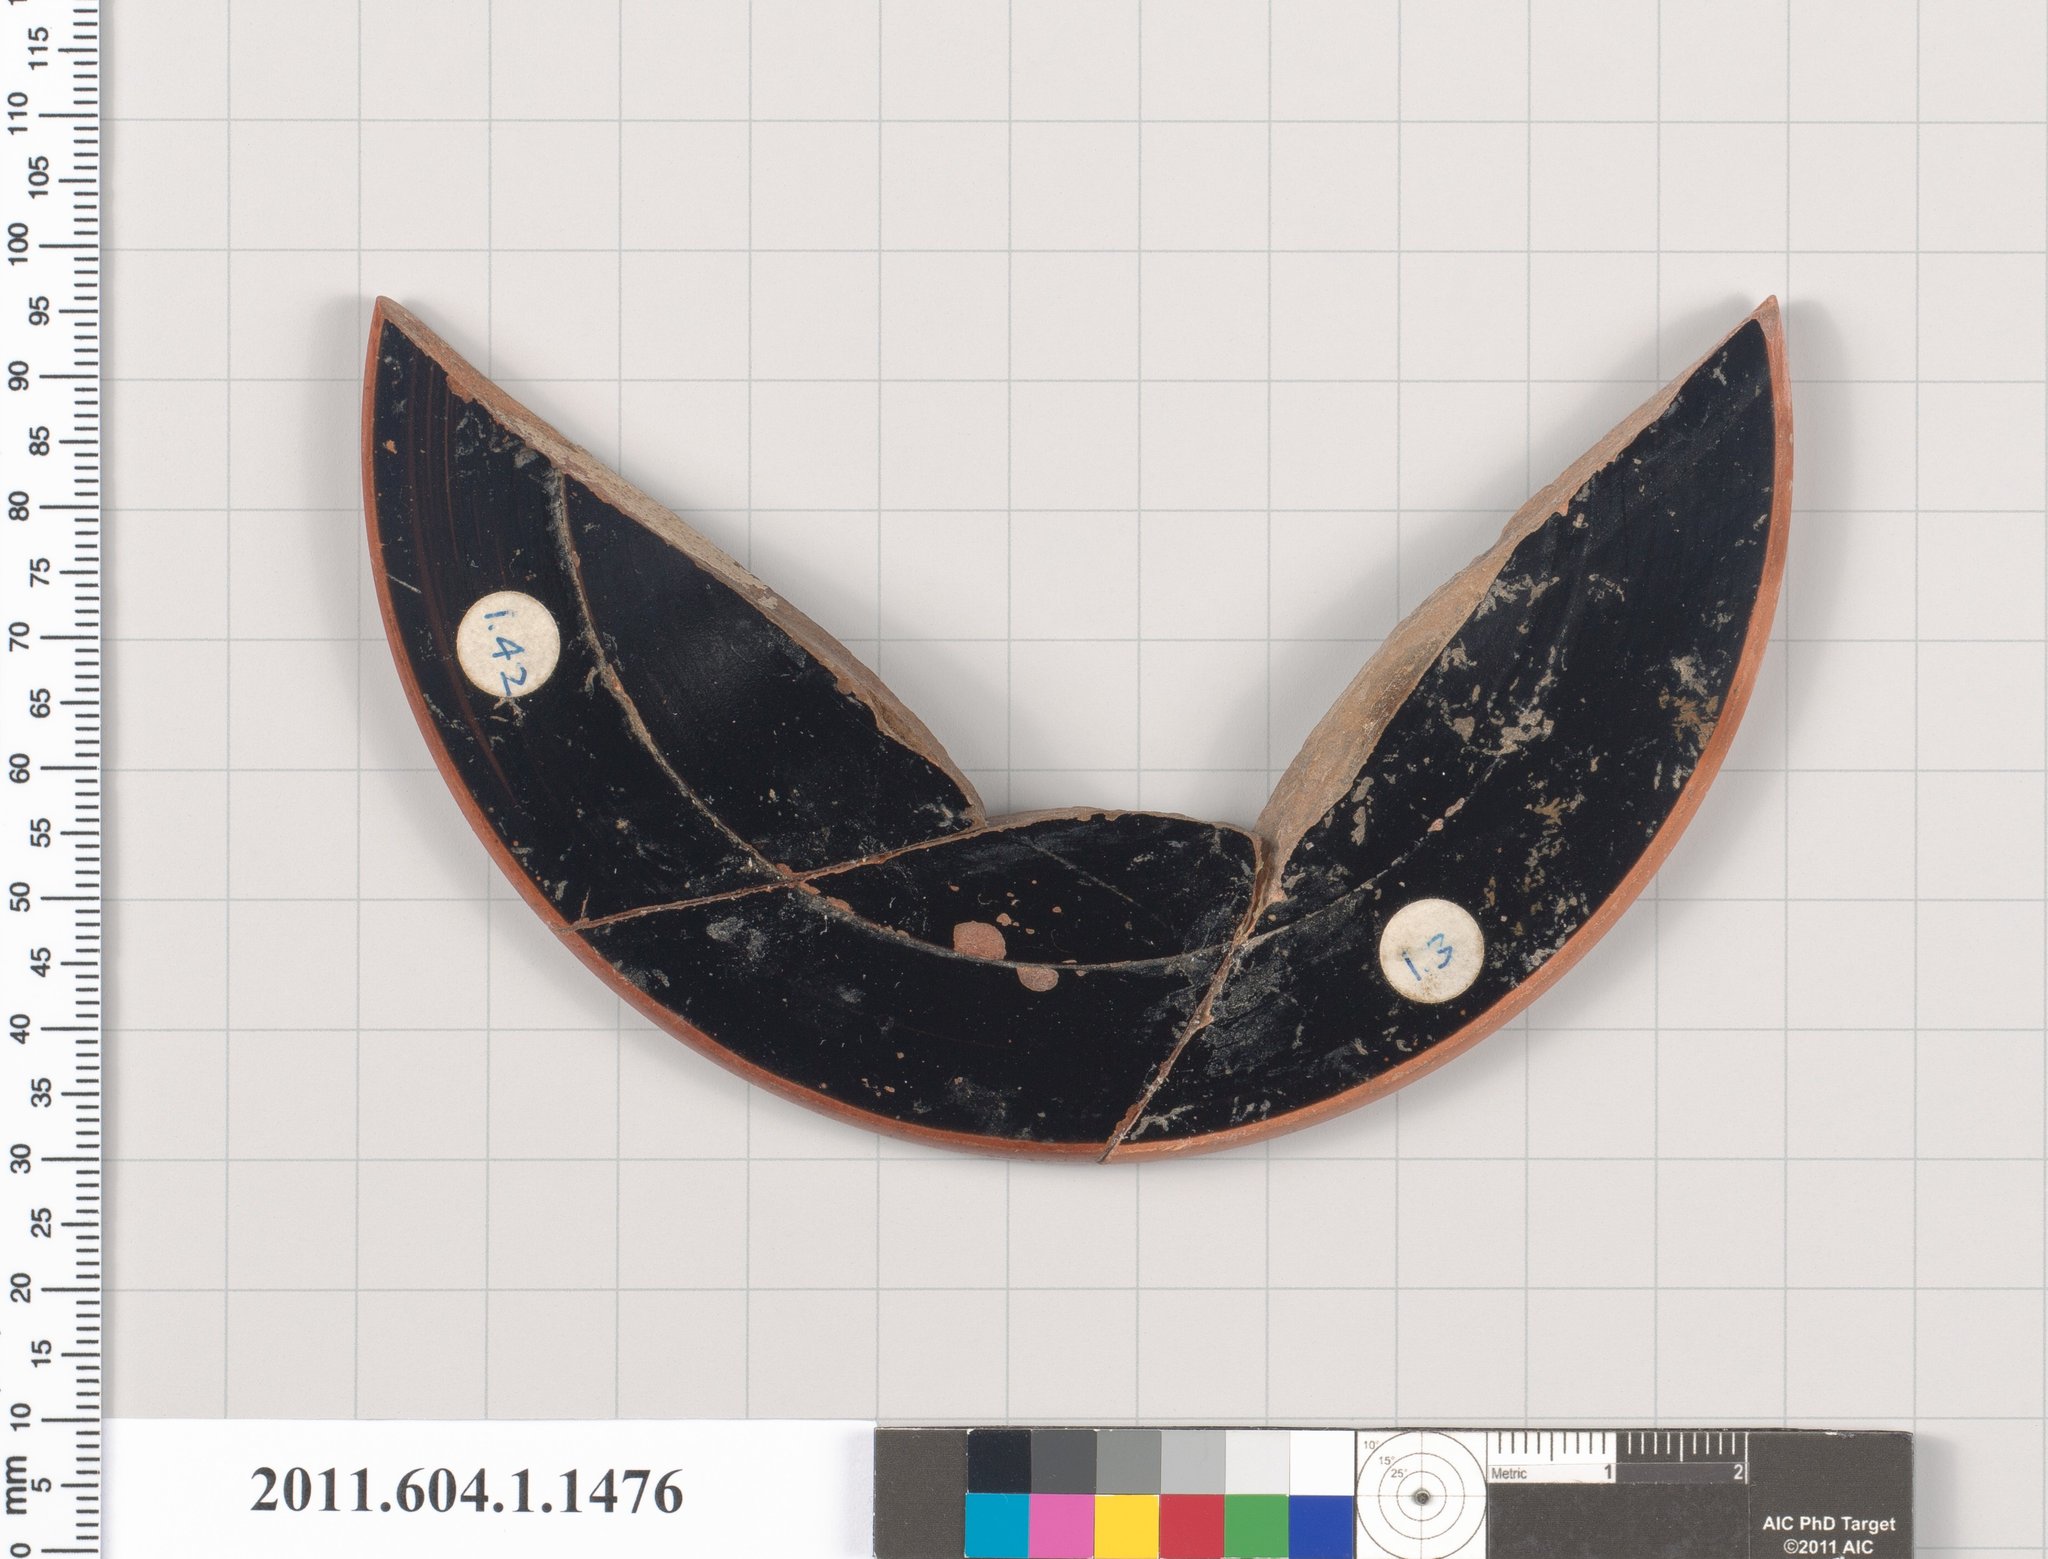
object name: kylix fragment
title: Terracotta fragment of a kylix (drinking cup)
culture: greek, attic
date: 500-401 BCE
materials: terracotta